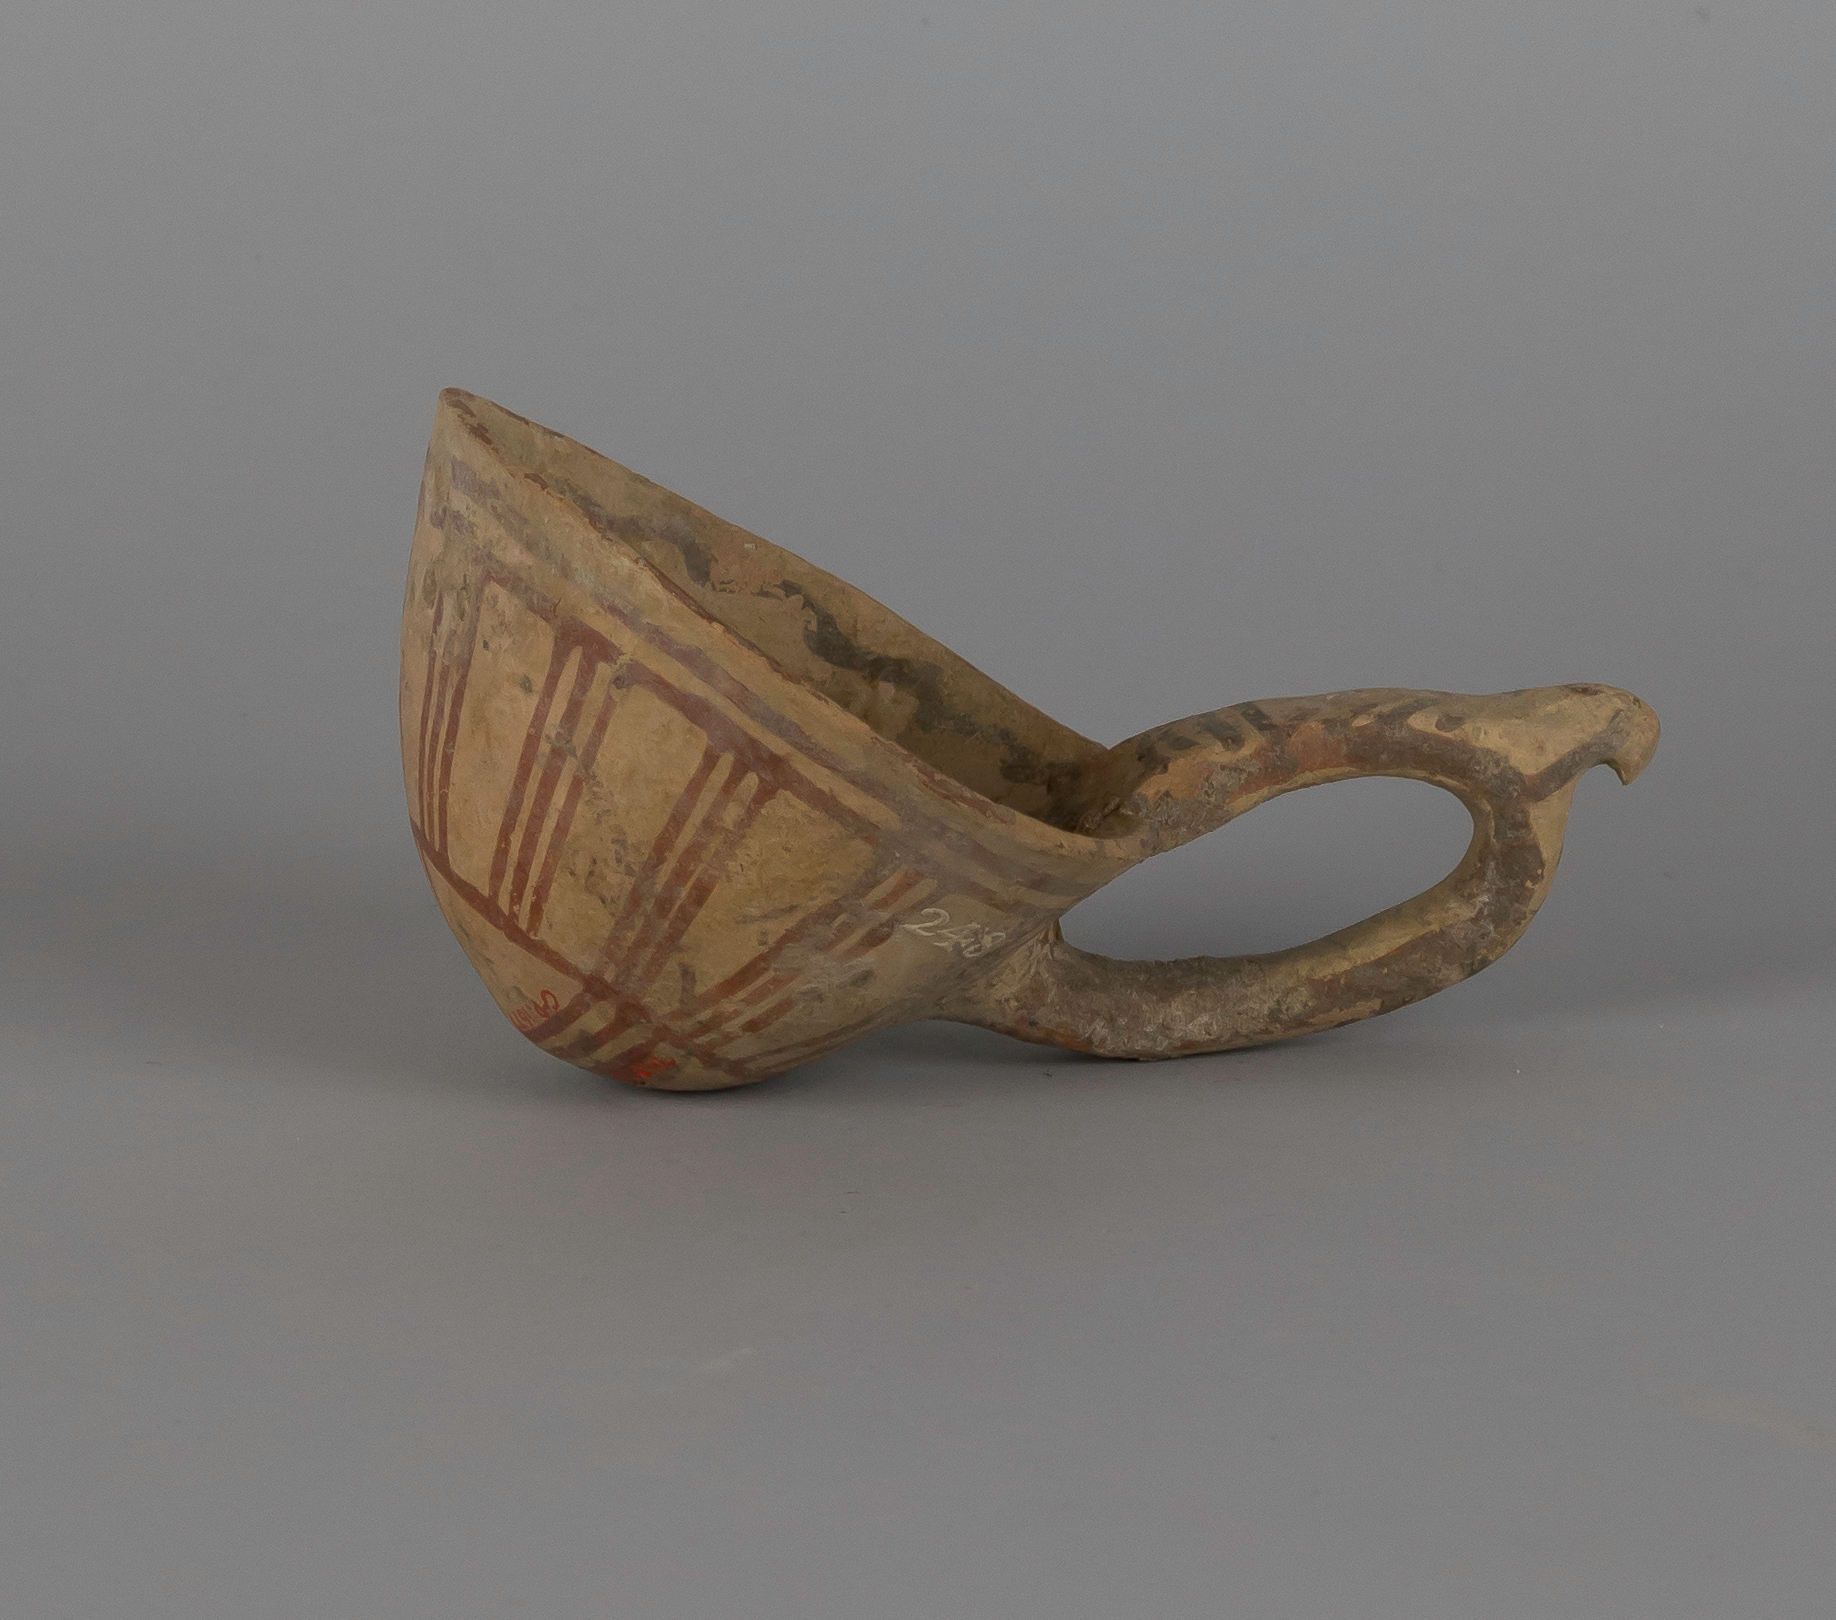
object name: cup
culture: cypriot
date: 2000-1600 BCE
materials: terracotta